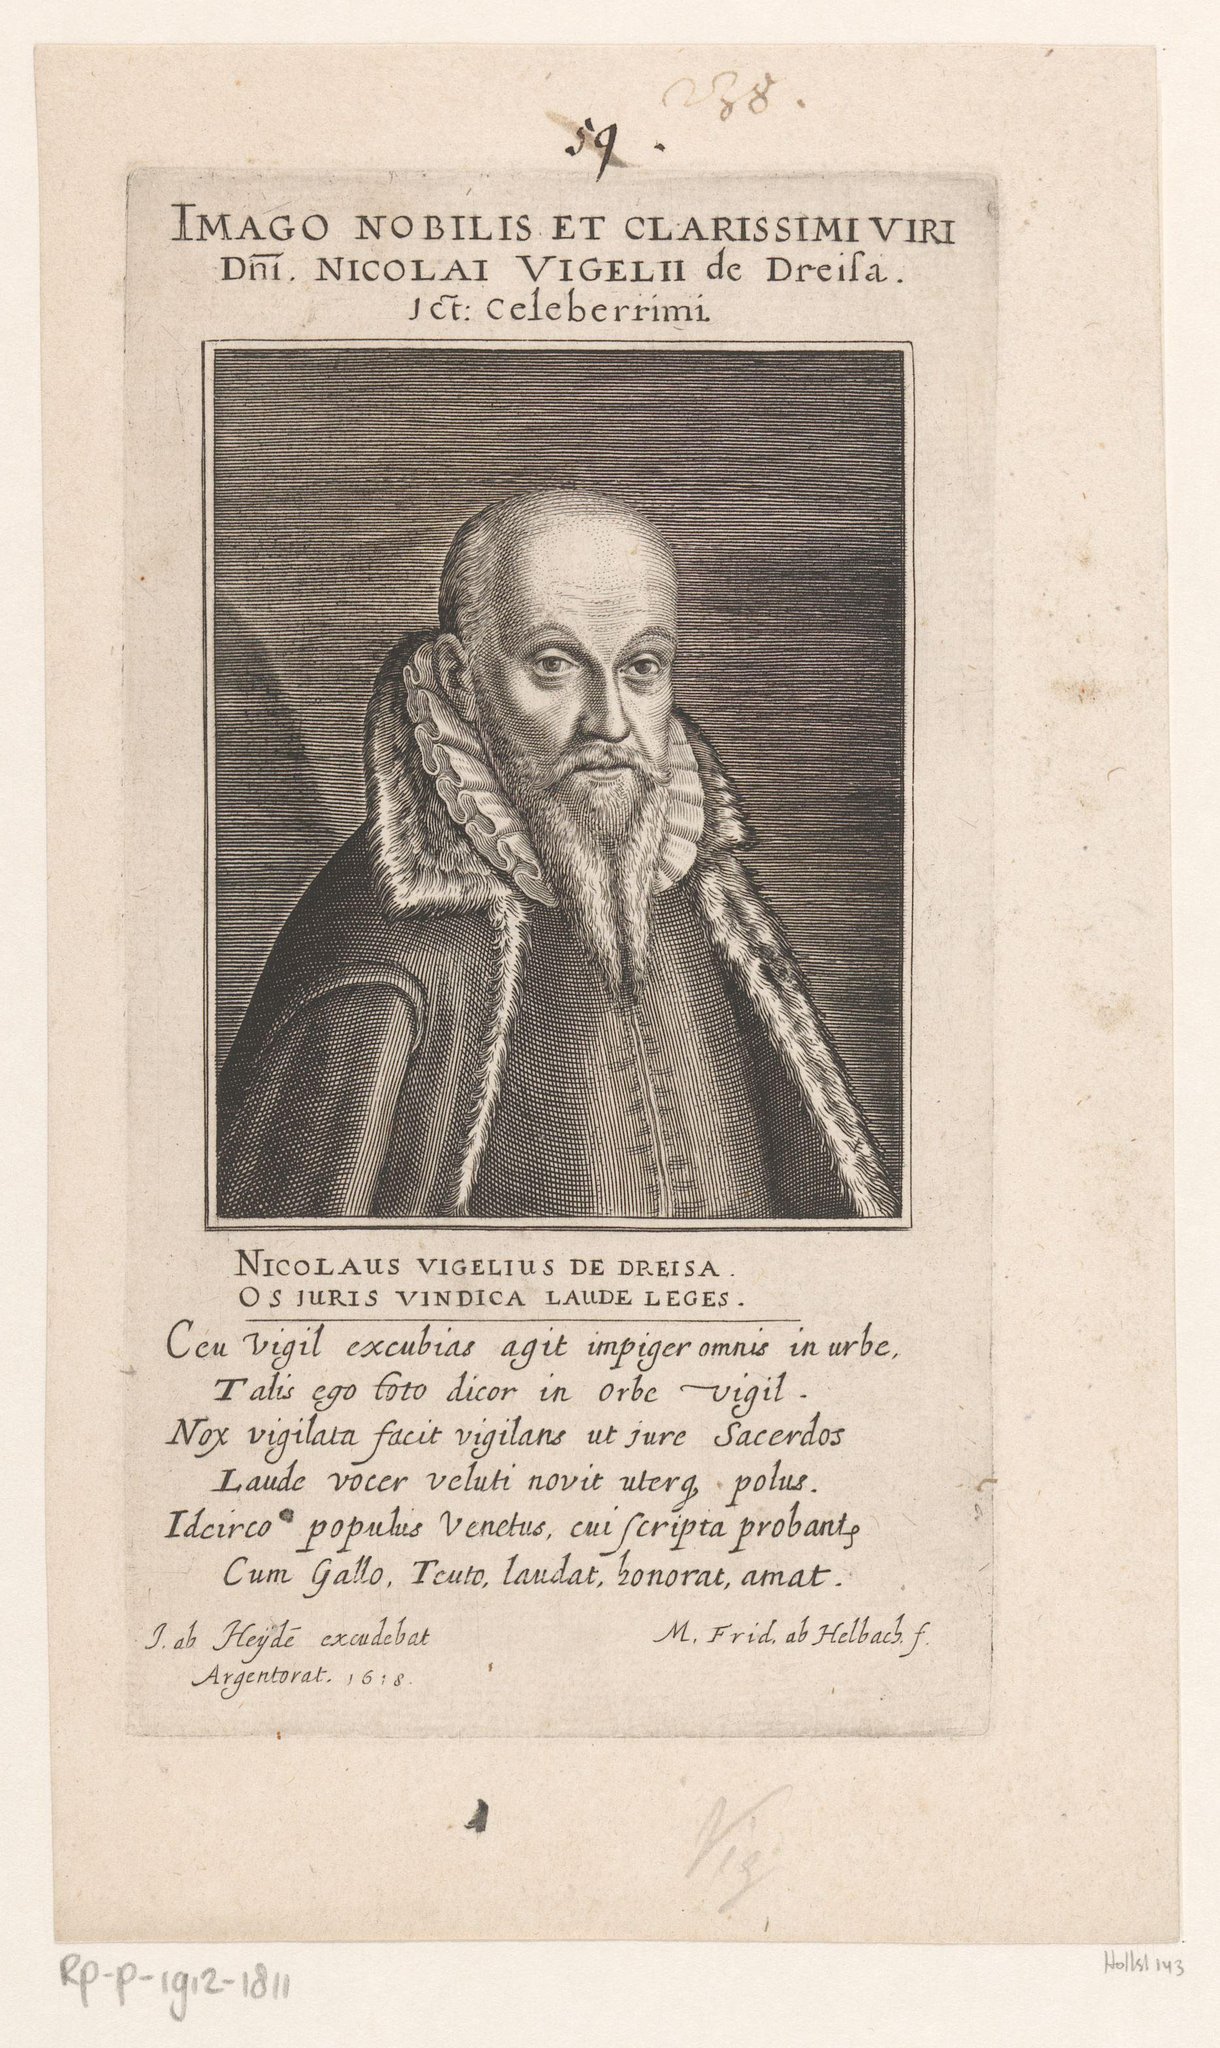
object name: print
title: Portret van Nikolaus Vigel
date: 1618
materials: paper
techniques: engraving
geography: straatsburg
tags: historical persons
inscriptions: number: ‘59.’, collector's mark: Lugt 2228